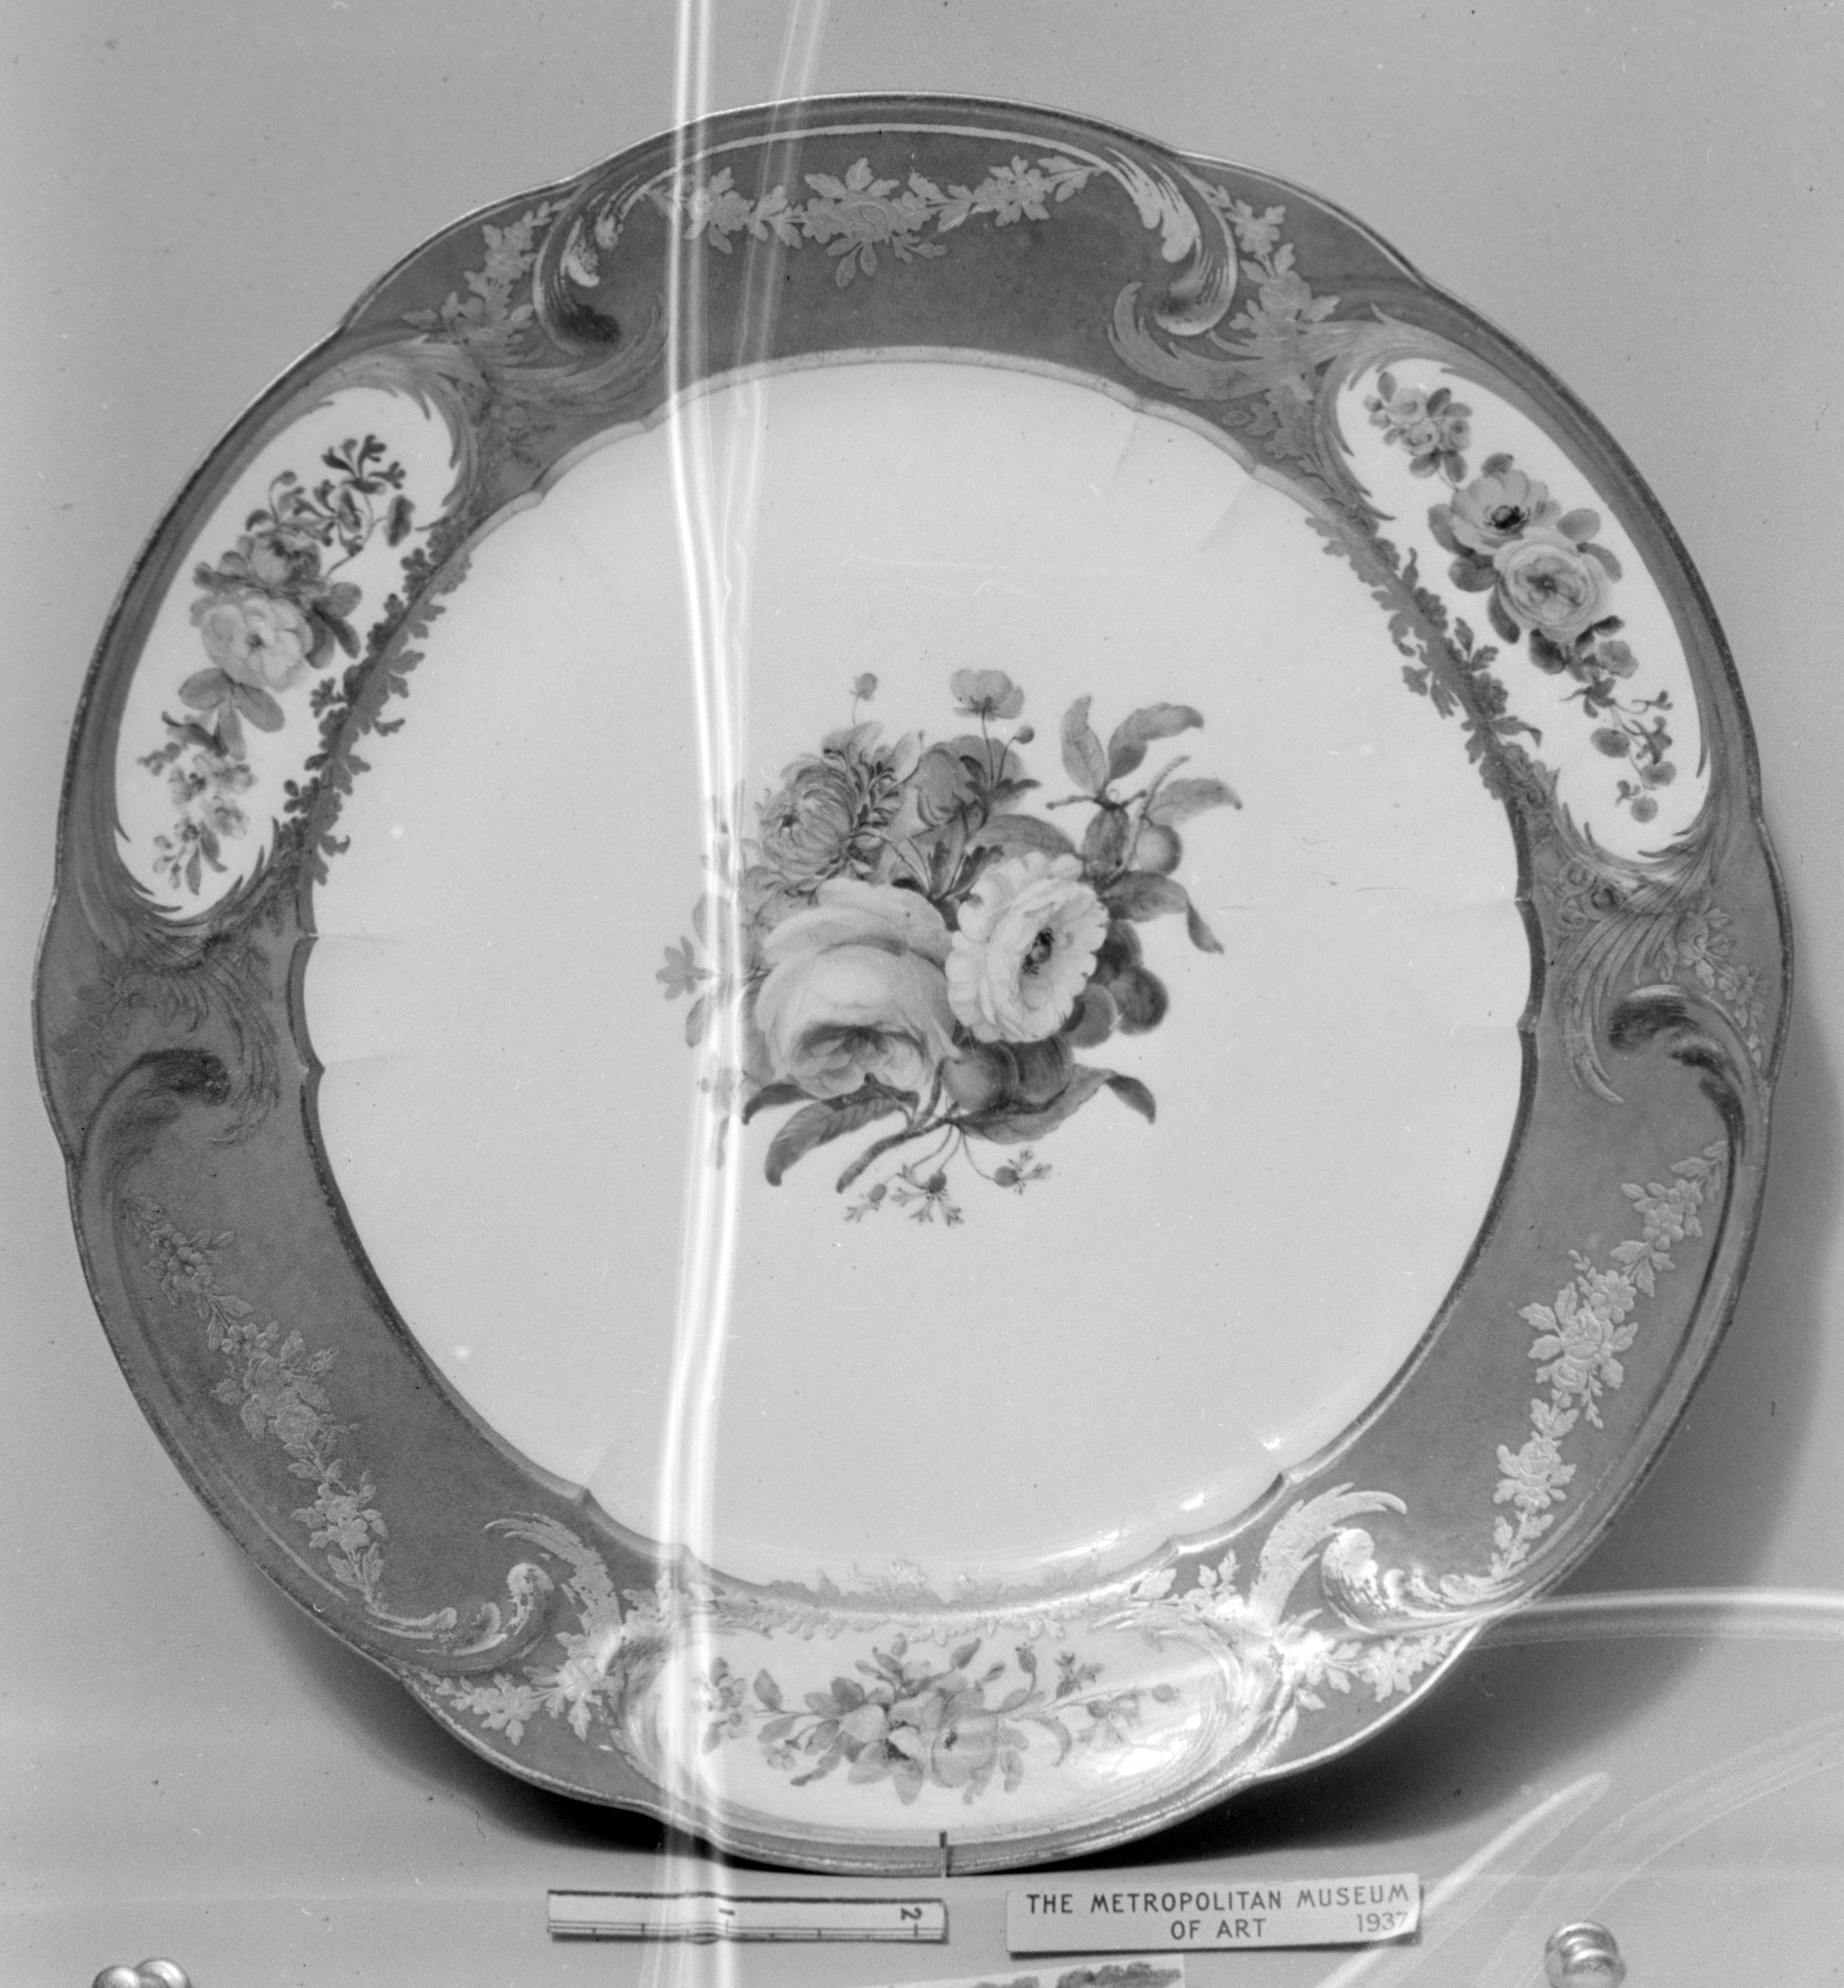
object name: plate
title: Plate (Assiette à palmes) (1 of 102) (part of a service)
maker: sèvres manufactory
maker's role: manufactory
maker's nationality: french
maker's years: 1740-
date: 1786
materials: soft paste porcelain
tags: flowers